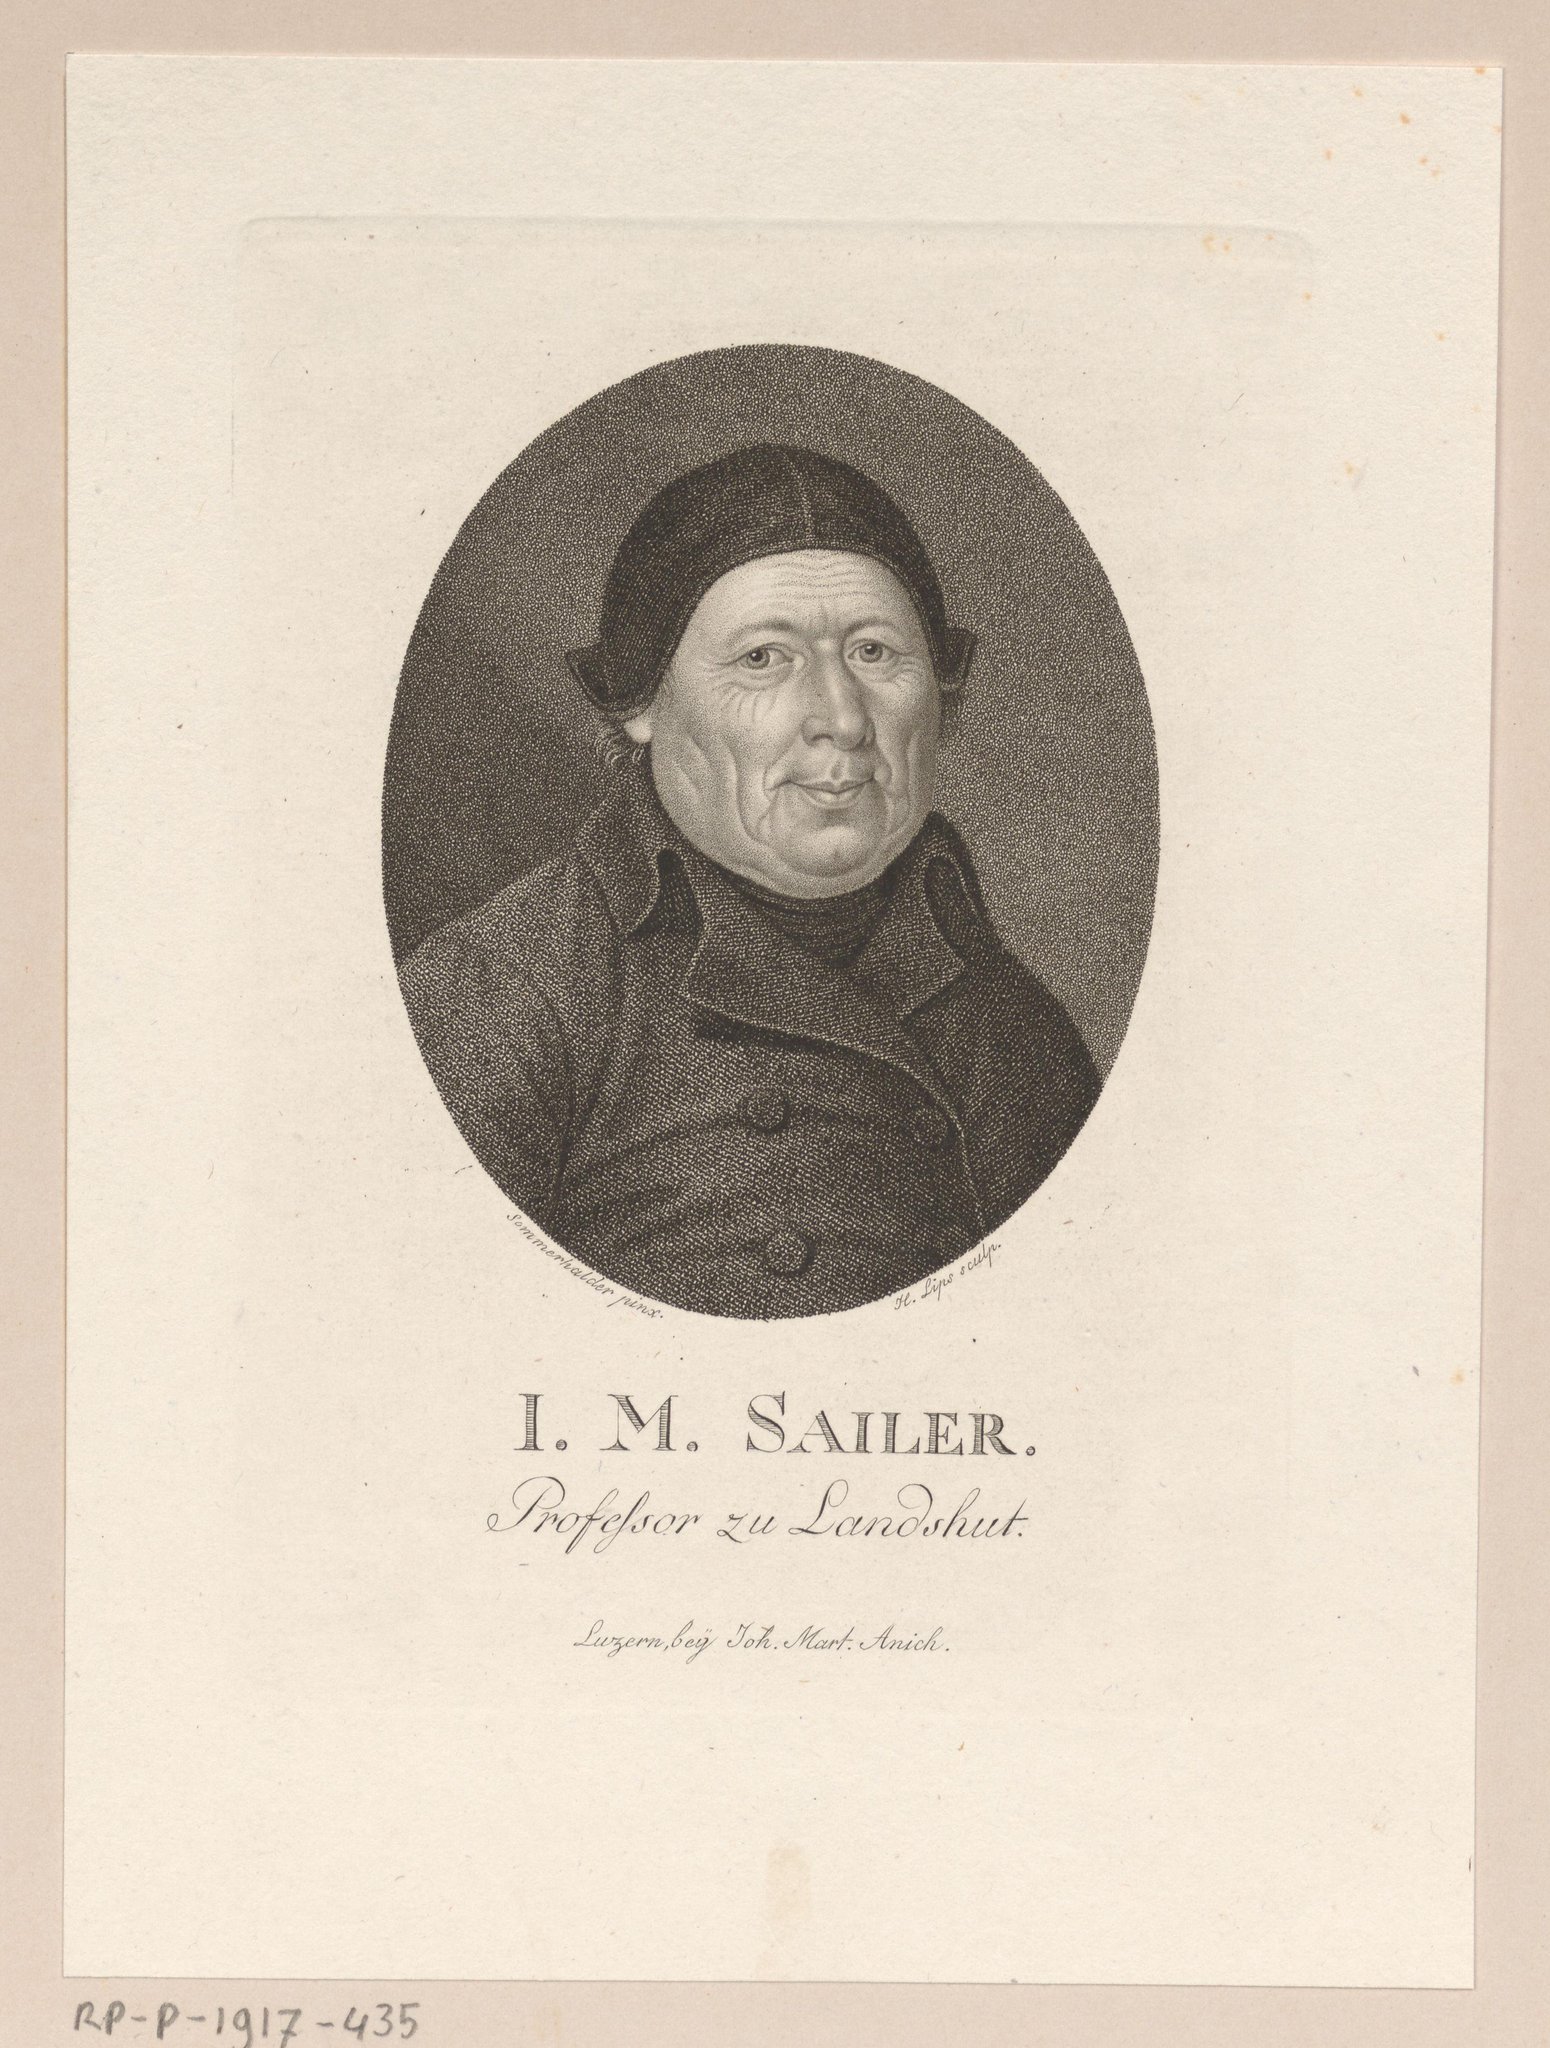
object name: print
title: Portret van Johann Michael Sailer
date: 1800-1817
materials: paper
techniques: etching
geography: lucerne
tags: archbishop, bishop, etc. (roman catholic), historical persons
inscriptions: collector's mark: Lugt 2228